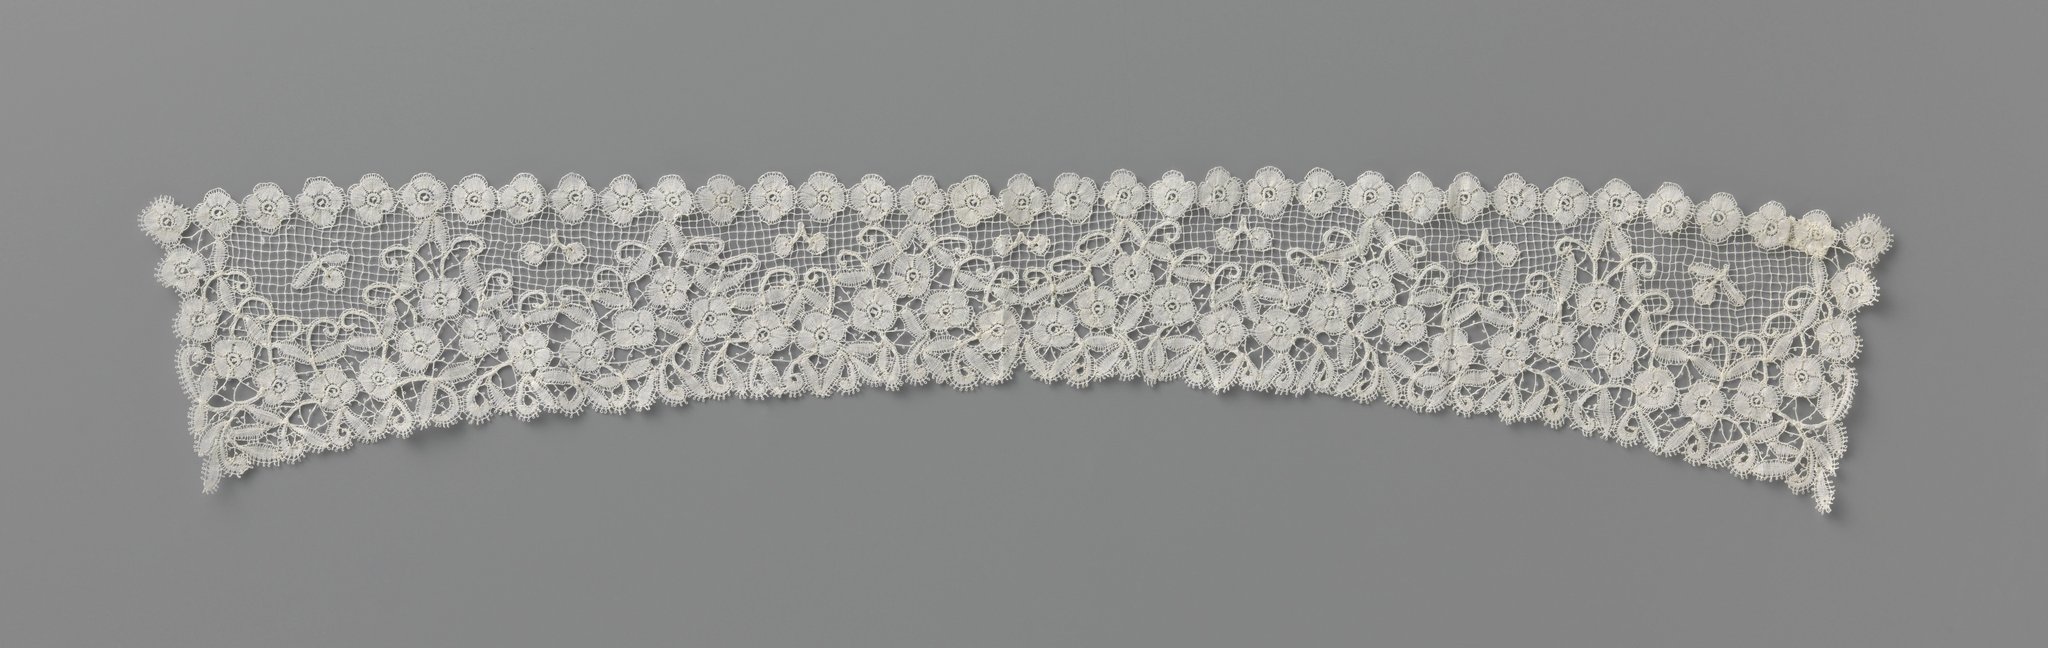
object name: guimpe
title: Guimpe van kloskant met boterbloempjes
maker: Anonymous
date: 1910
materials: linen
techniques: lace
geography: belgium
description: Guimpe van naturelkleurige kloskant: duchesse-kant. Rechthoekig model met iets verbrede uiteinden. De achtergrond, half traliegrond, half vlechtengrond, is door een boogjeslijst verdeeld. Op de traliegrond staan enige los gestrooide takjes met besjes en een randje van 'boterbloempjes' aan stengeltjes.